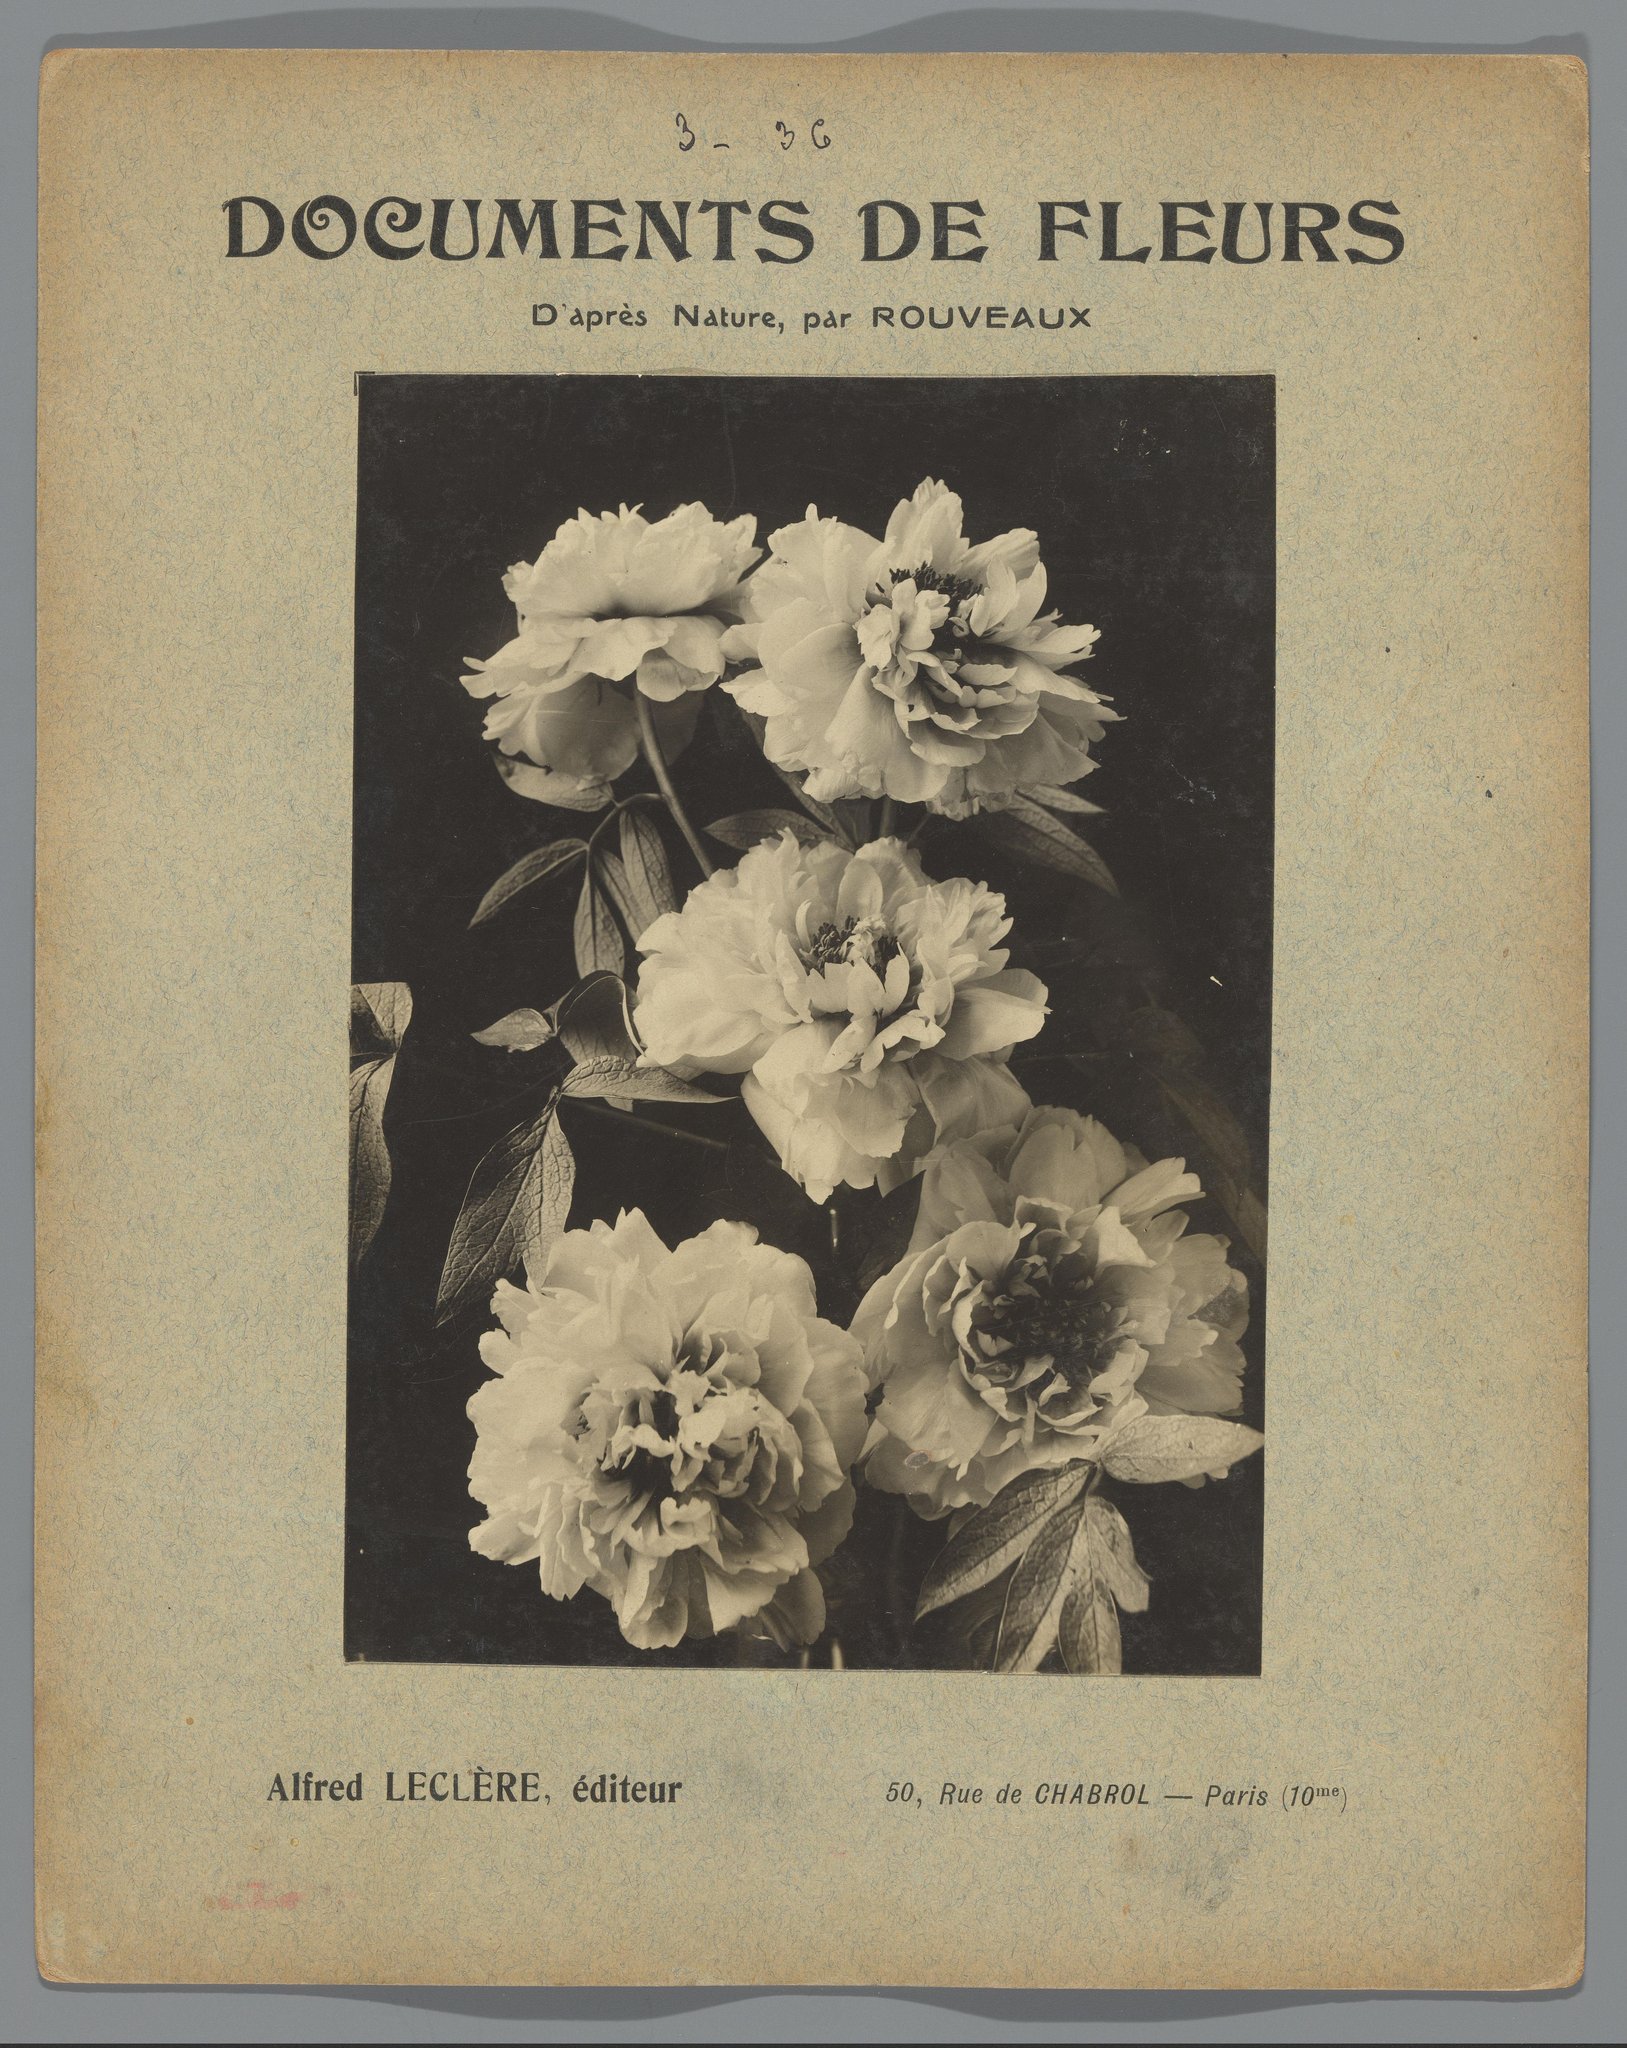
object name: photograph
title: Bloemstudie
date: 1895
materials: photographic support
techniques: gelatin silver print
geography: france